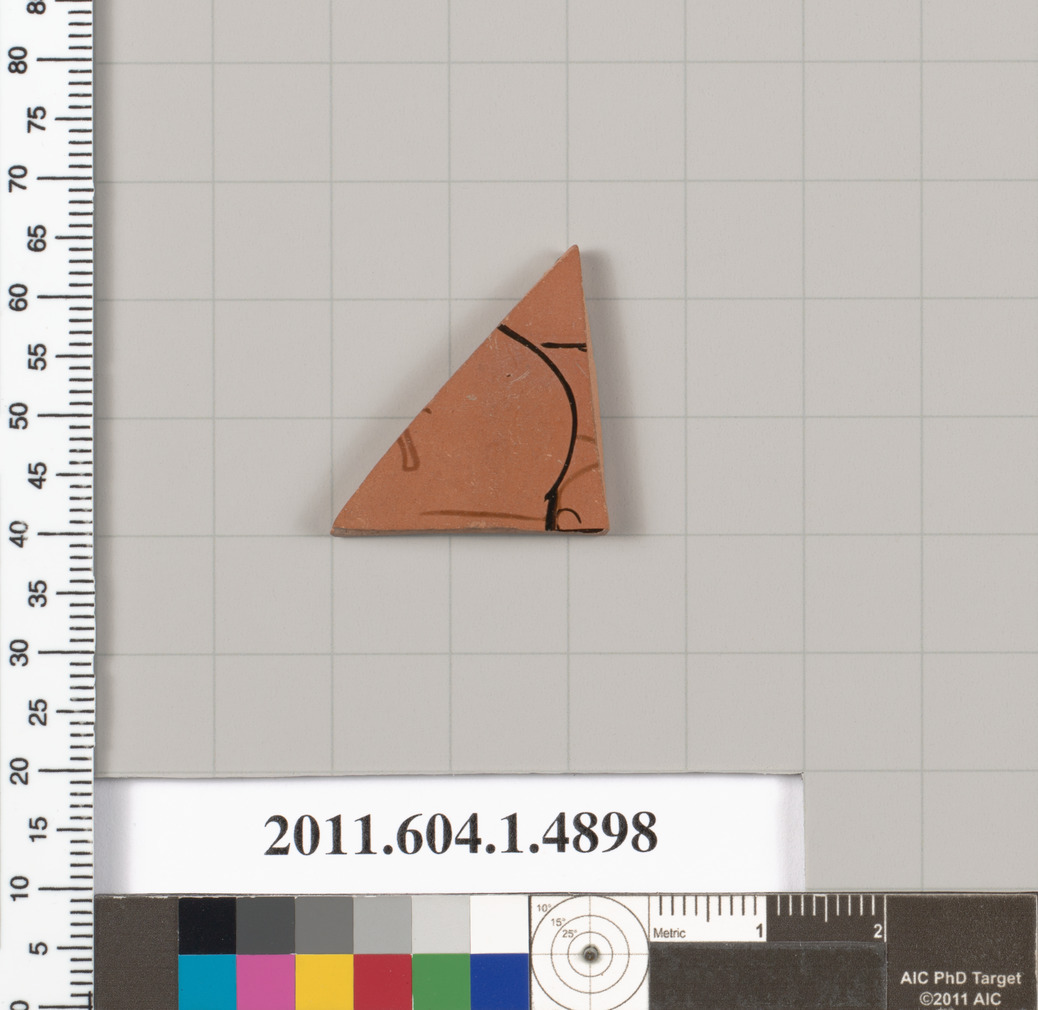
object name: kylix fragment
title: Terracotta fragment of a kylix (drinking cup)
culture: greek, attic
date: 490-480 BCE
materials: terracotta